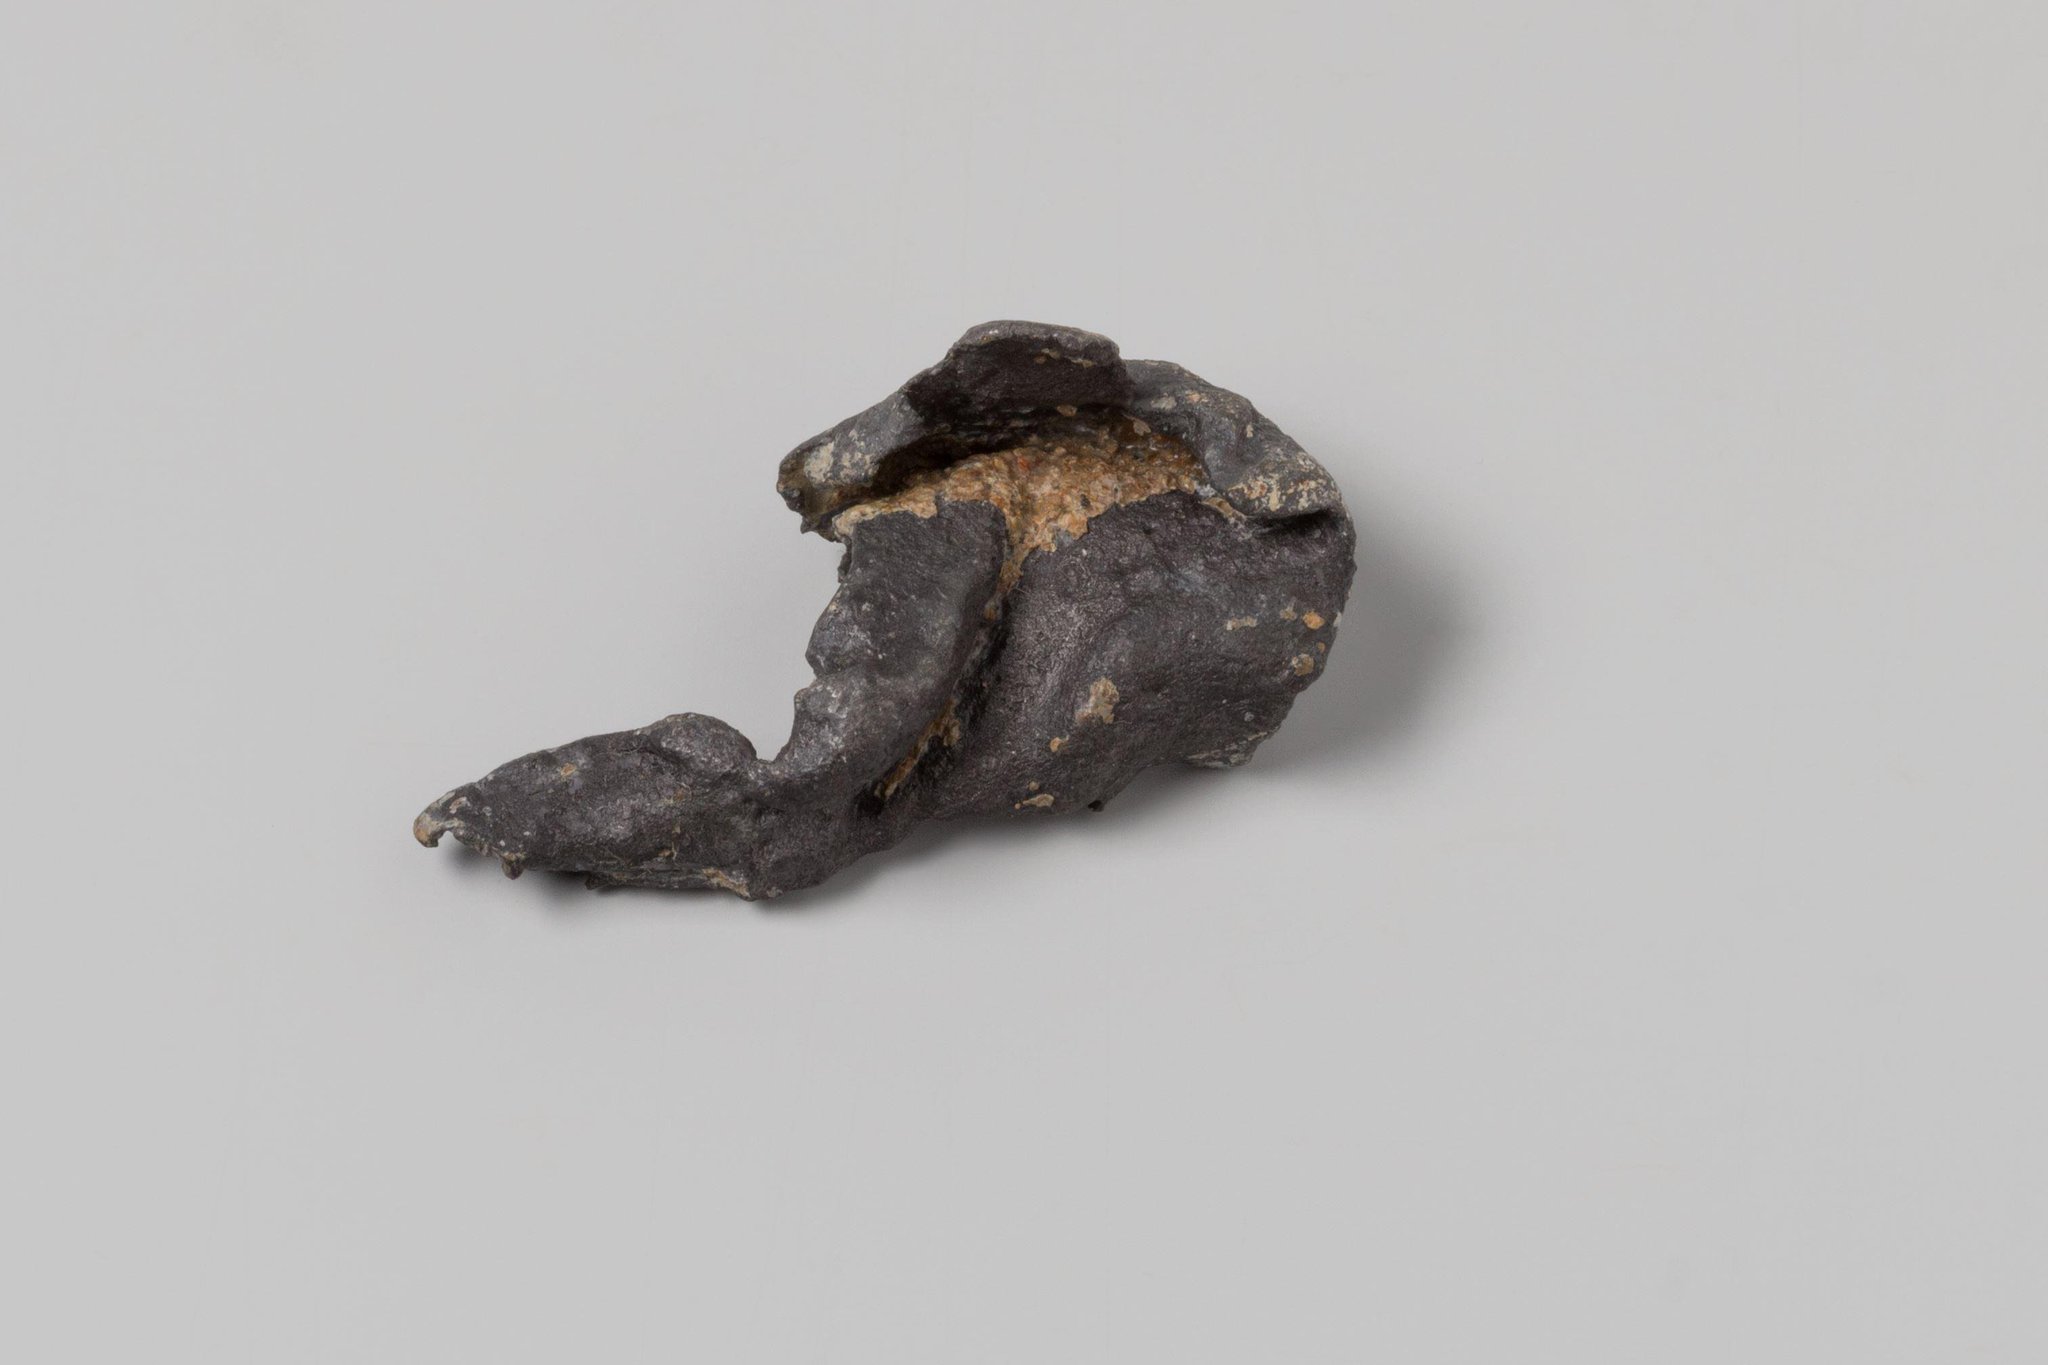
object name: fragment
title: Fragment lood uit het wrak van de Oost-Indiëvaarder Hollandia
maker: Anonymous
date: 1700-1743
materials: lead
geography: netherlands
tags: verenigde oostindische compagnie, hollandia (schip), annet